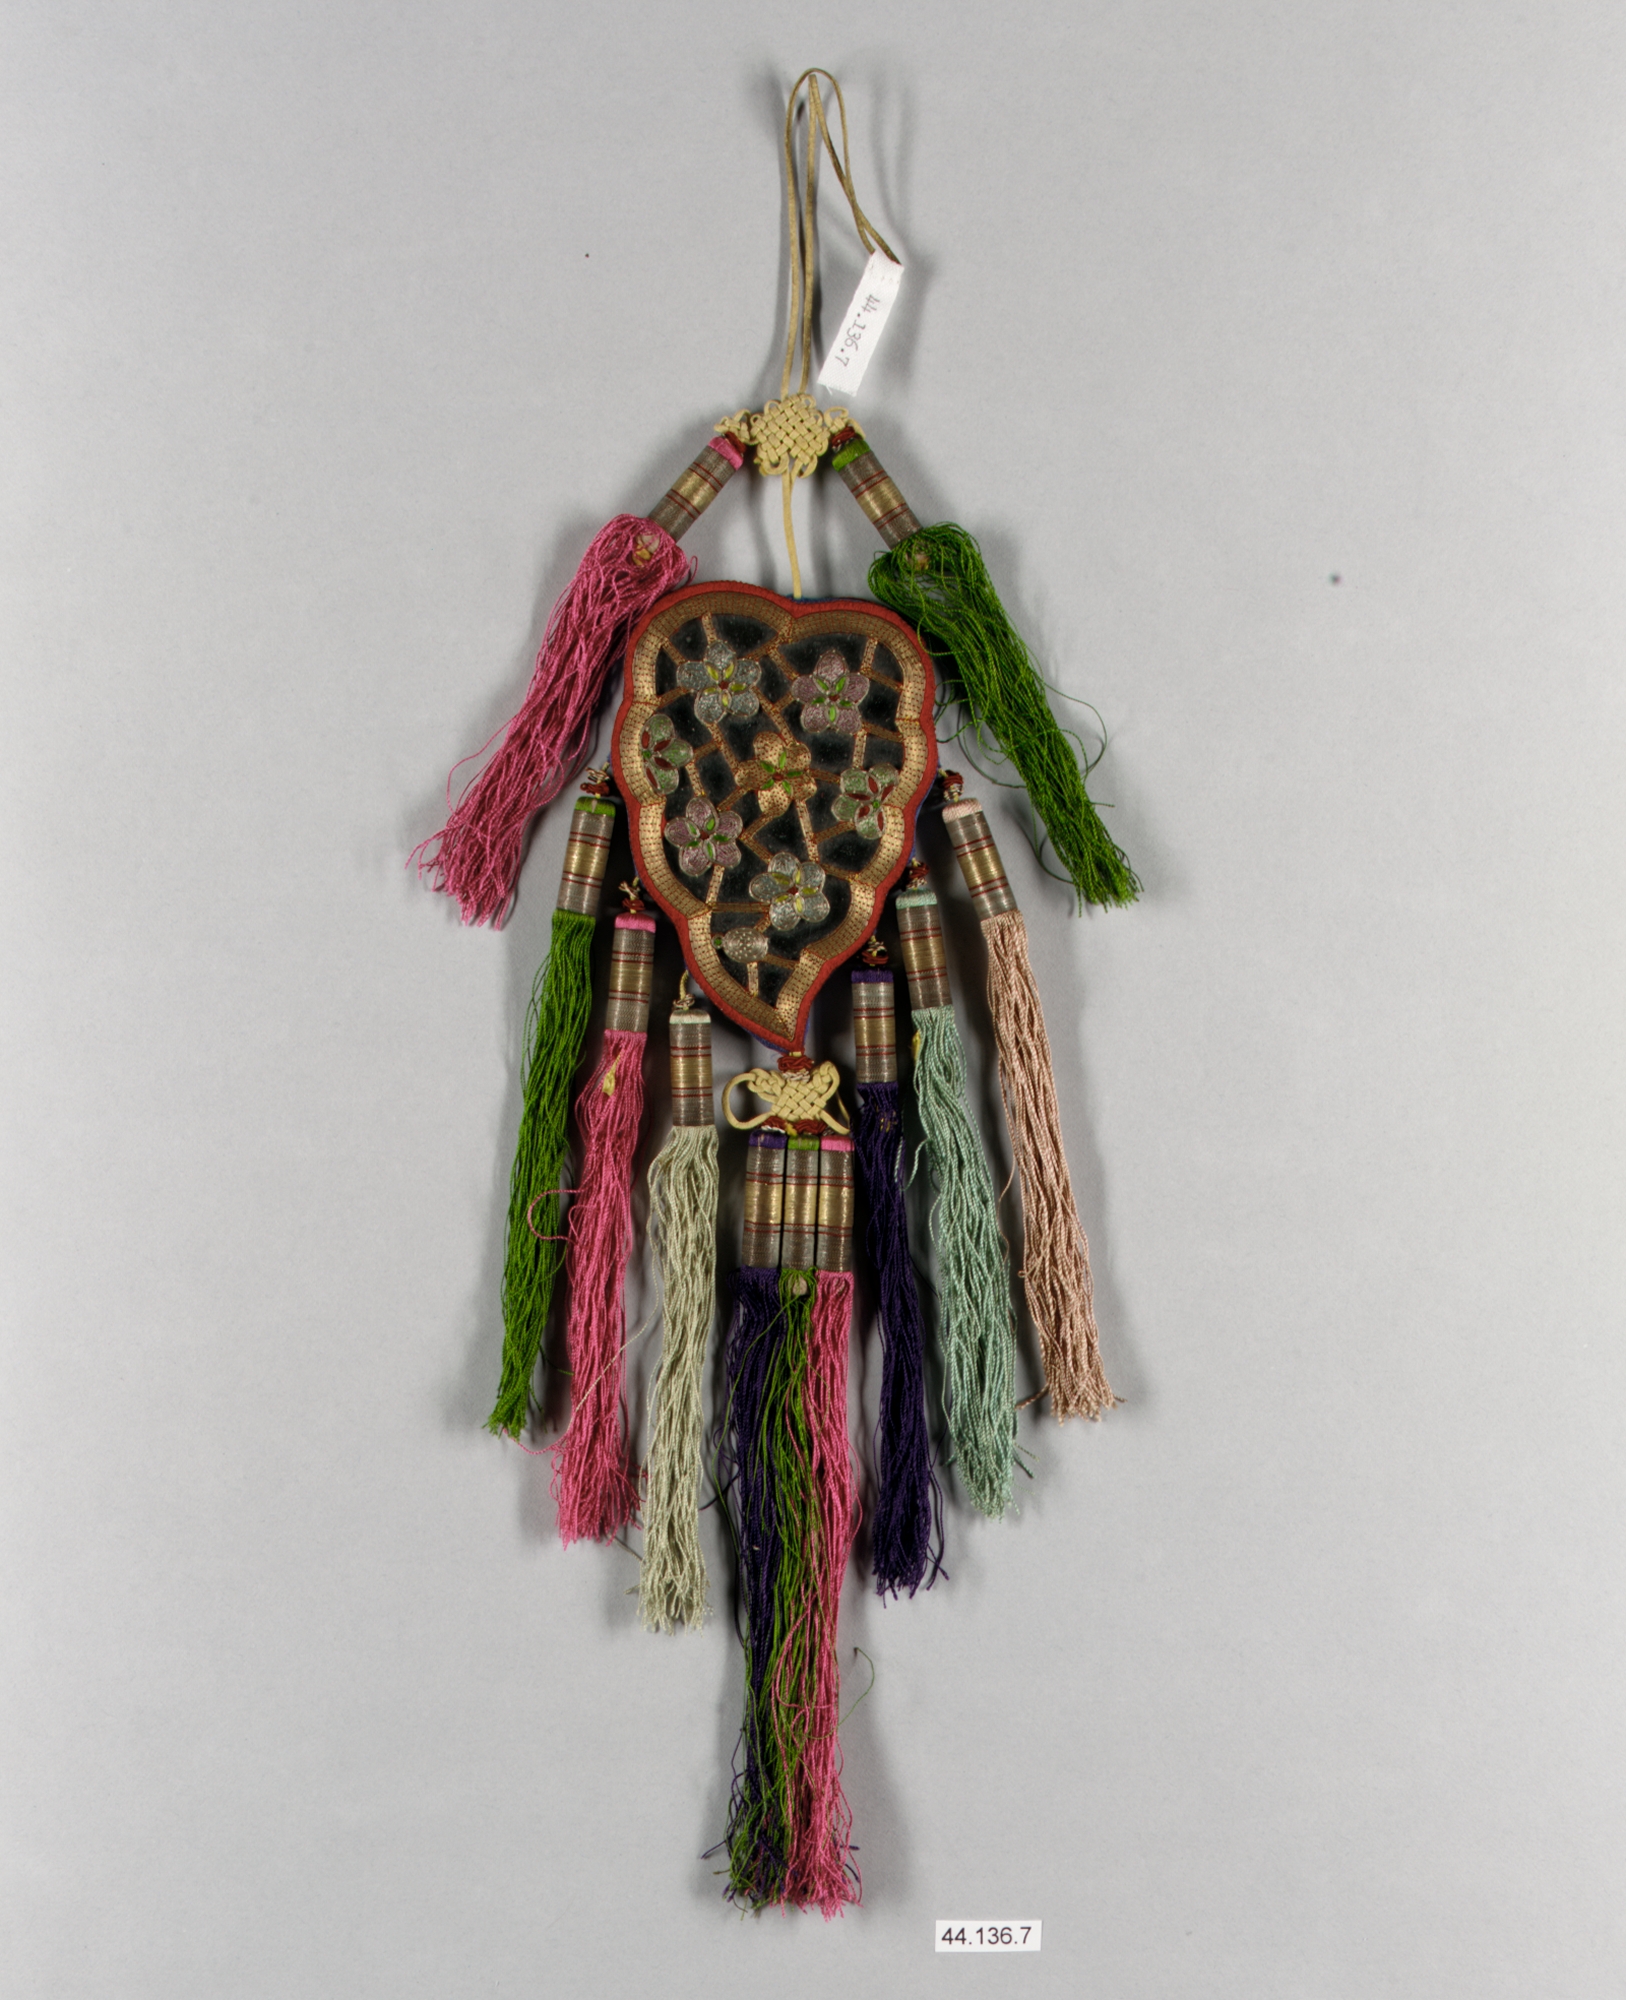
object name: mirror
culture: chinese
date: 1801-1900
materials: glass, metal thread, silk